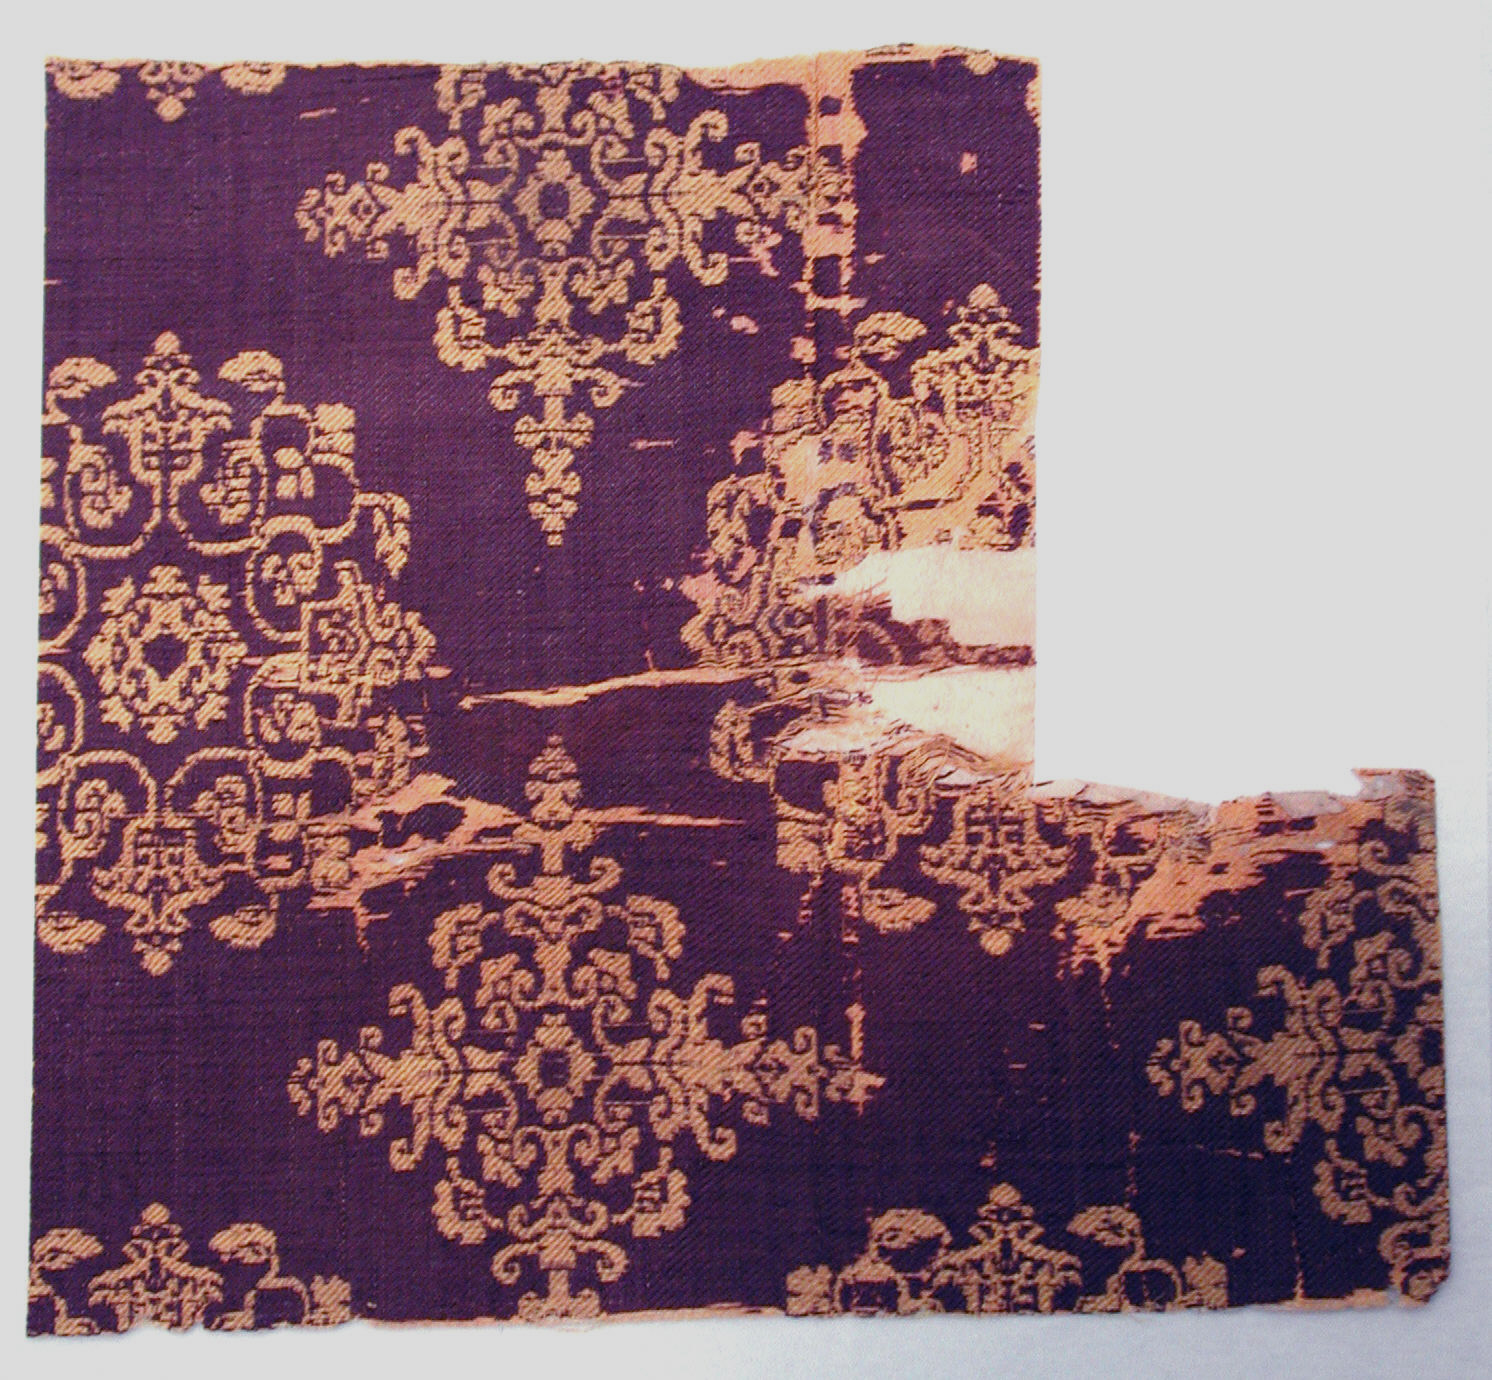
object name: fragment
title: Textile with floral medallions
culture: chinese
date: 701-800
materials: silk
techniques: weave